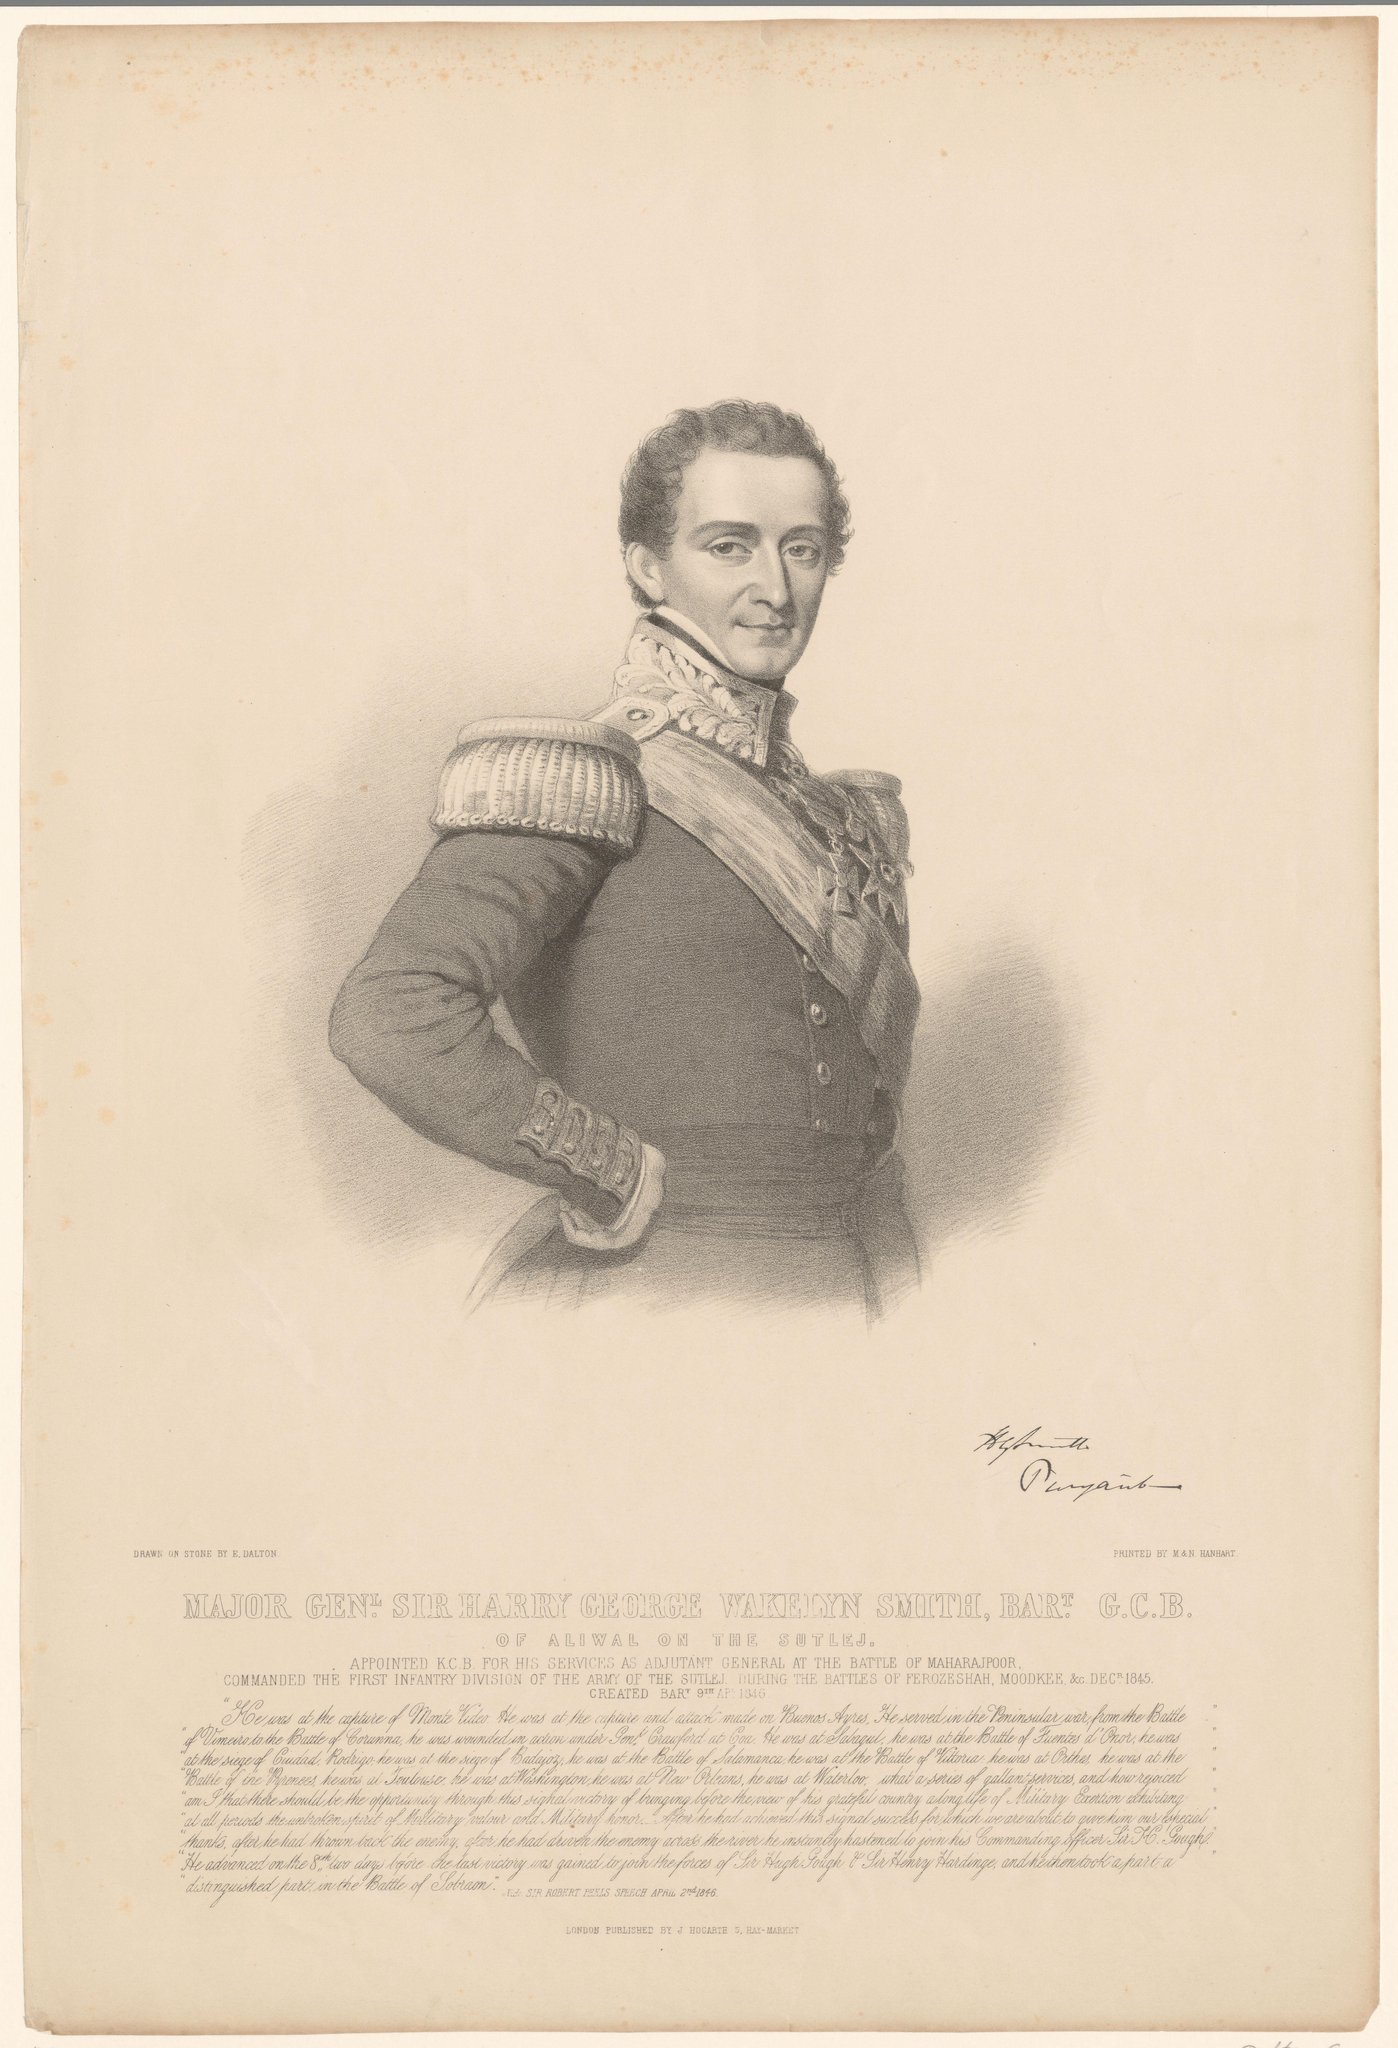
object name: print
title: Portret van Harry George Wakelyn Smith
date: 1846-1850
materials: paper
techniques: lithograph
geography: london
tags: adult man, historical persons, (military) uniforms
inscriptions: collector's mark: Lugt 2228